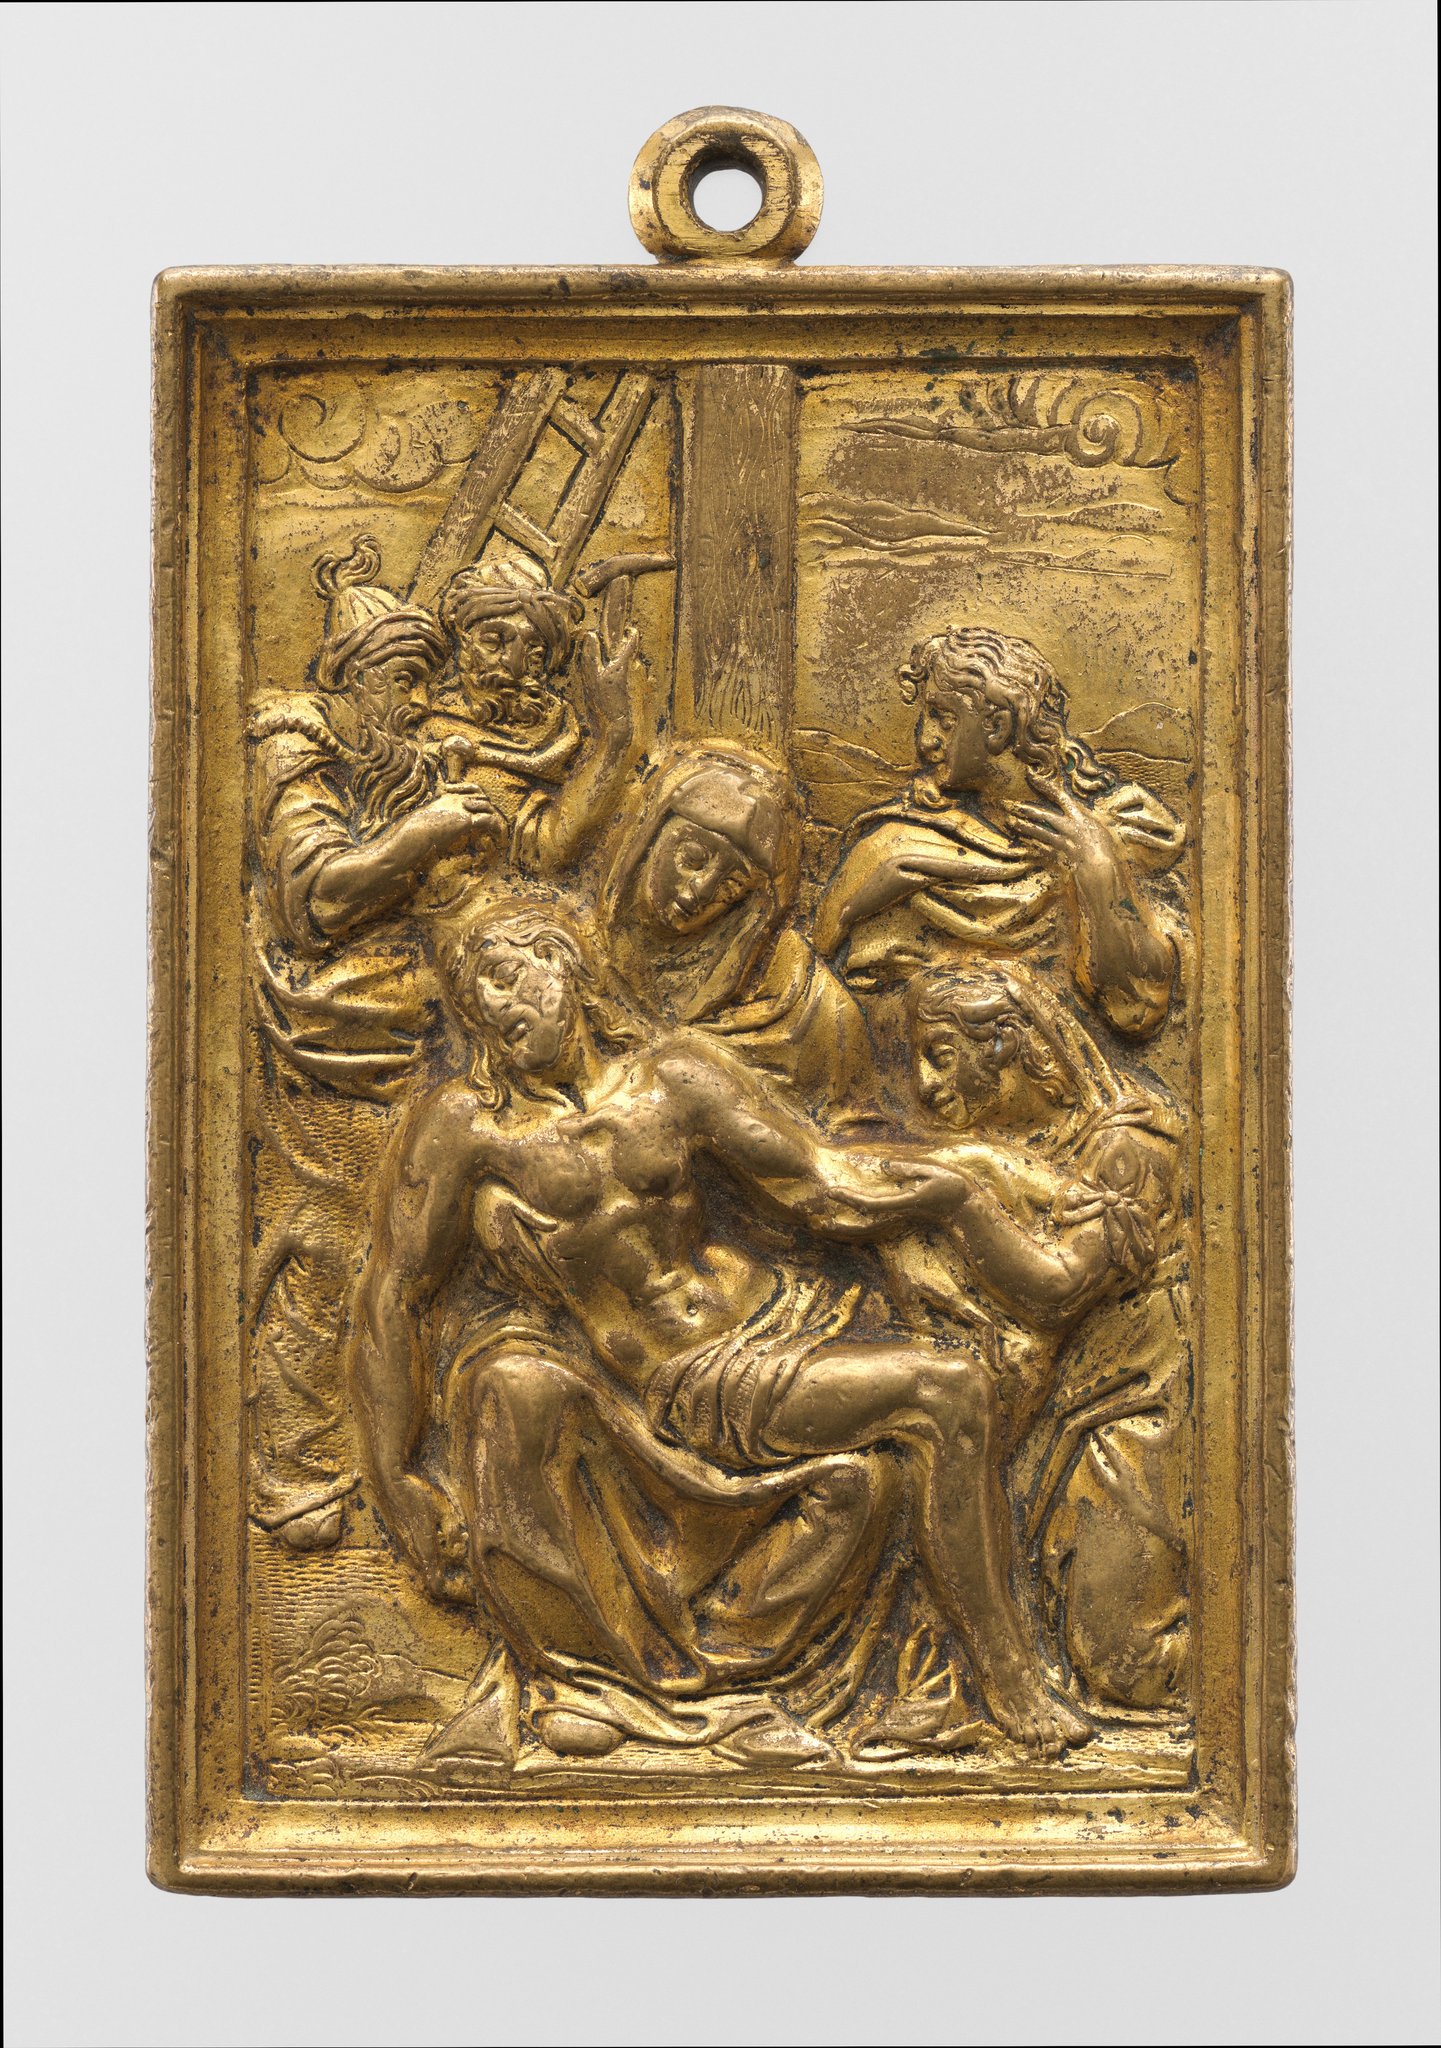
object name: plaquette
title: Lamentation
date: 1601-1633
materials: gilt bronze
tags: men,women,christ,virgin mary,lamentation